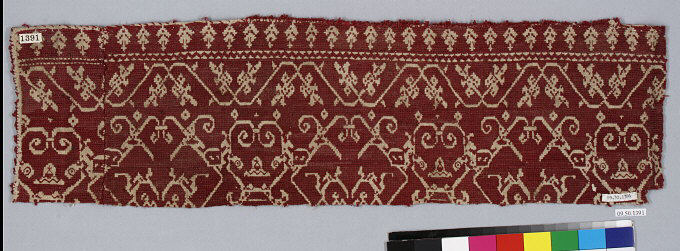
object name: fragment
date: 1501-1700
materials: linen, silk